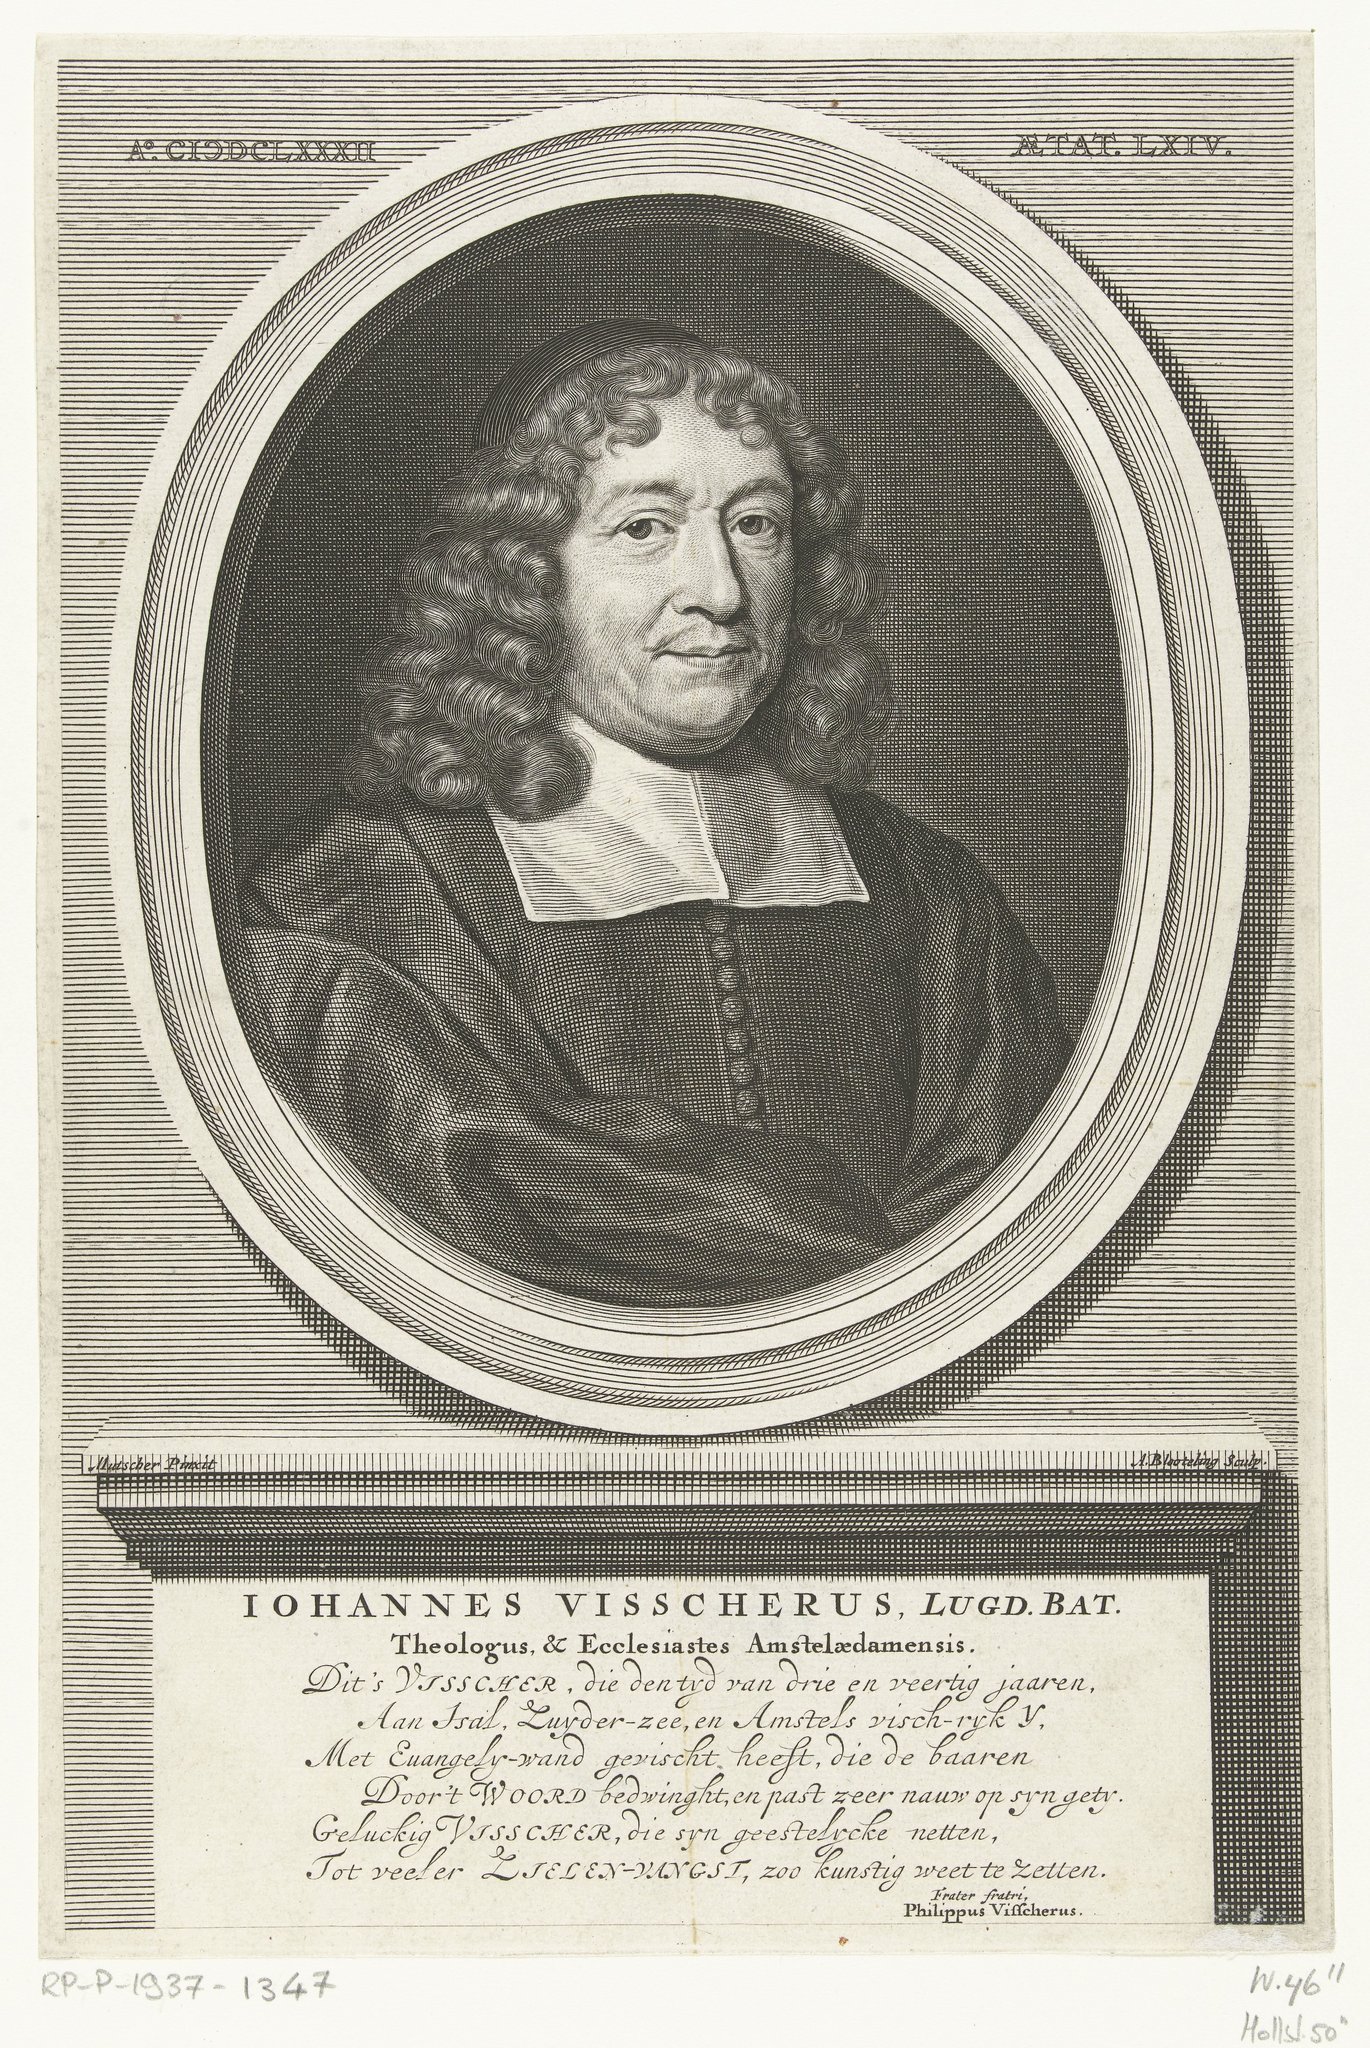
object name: print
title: Iohannes Visscherus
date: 1682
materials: paper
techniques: engraving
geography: amsterdam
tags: amsterdam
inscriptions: collector's mark: Lugt 2228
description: Borstbeeld van de Amsterdamse predikant Johannes Visscher. Onder het portret een vers over Visscher in het Nederlands.